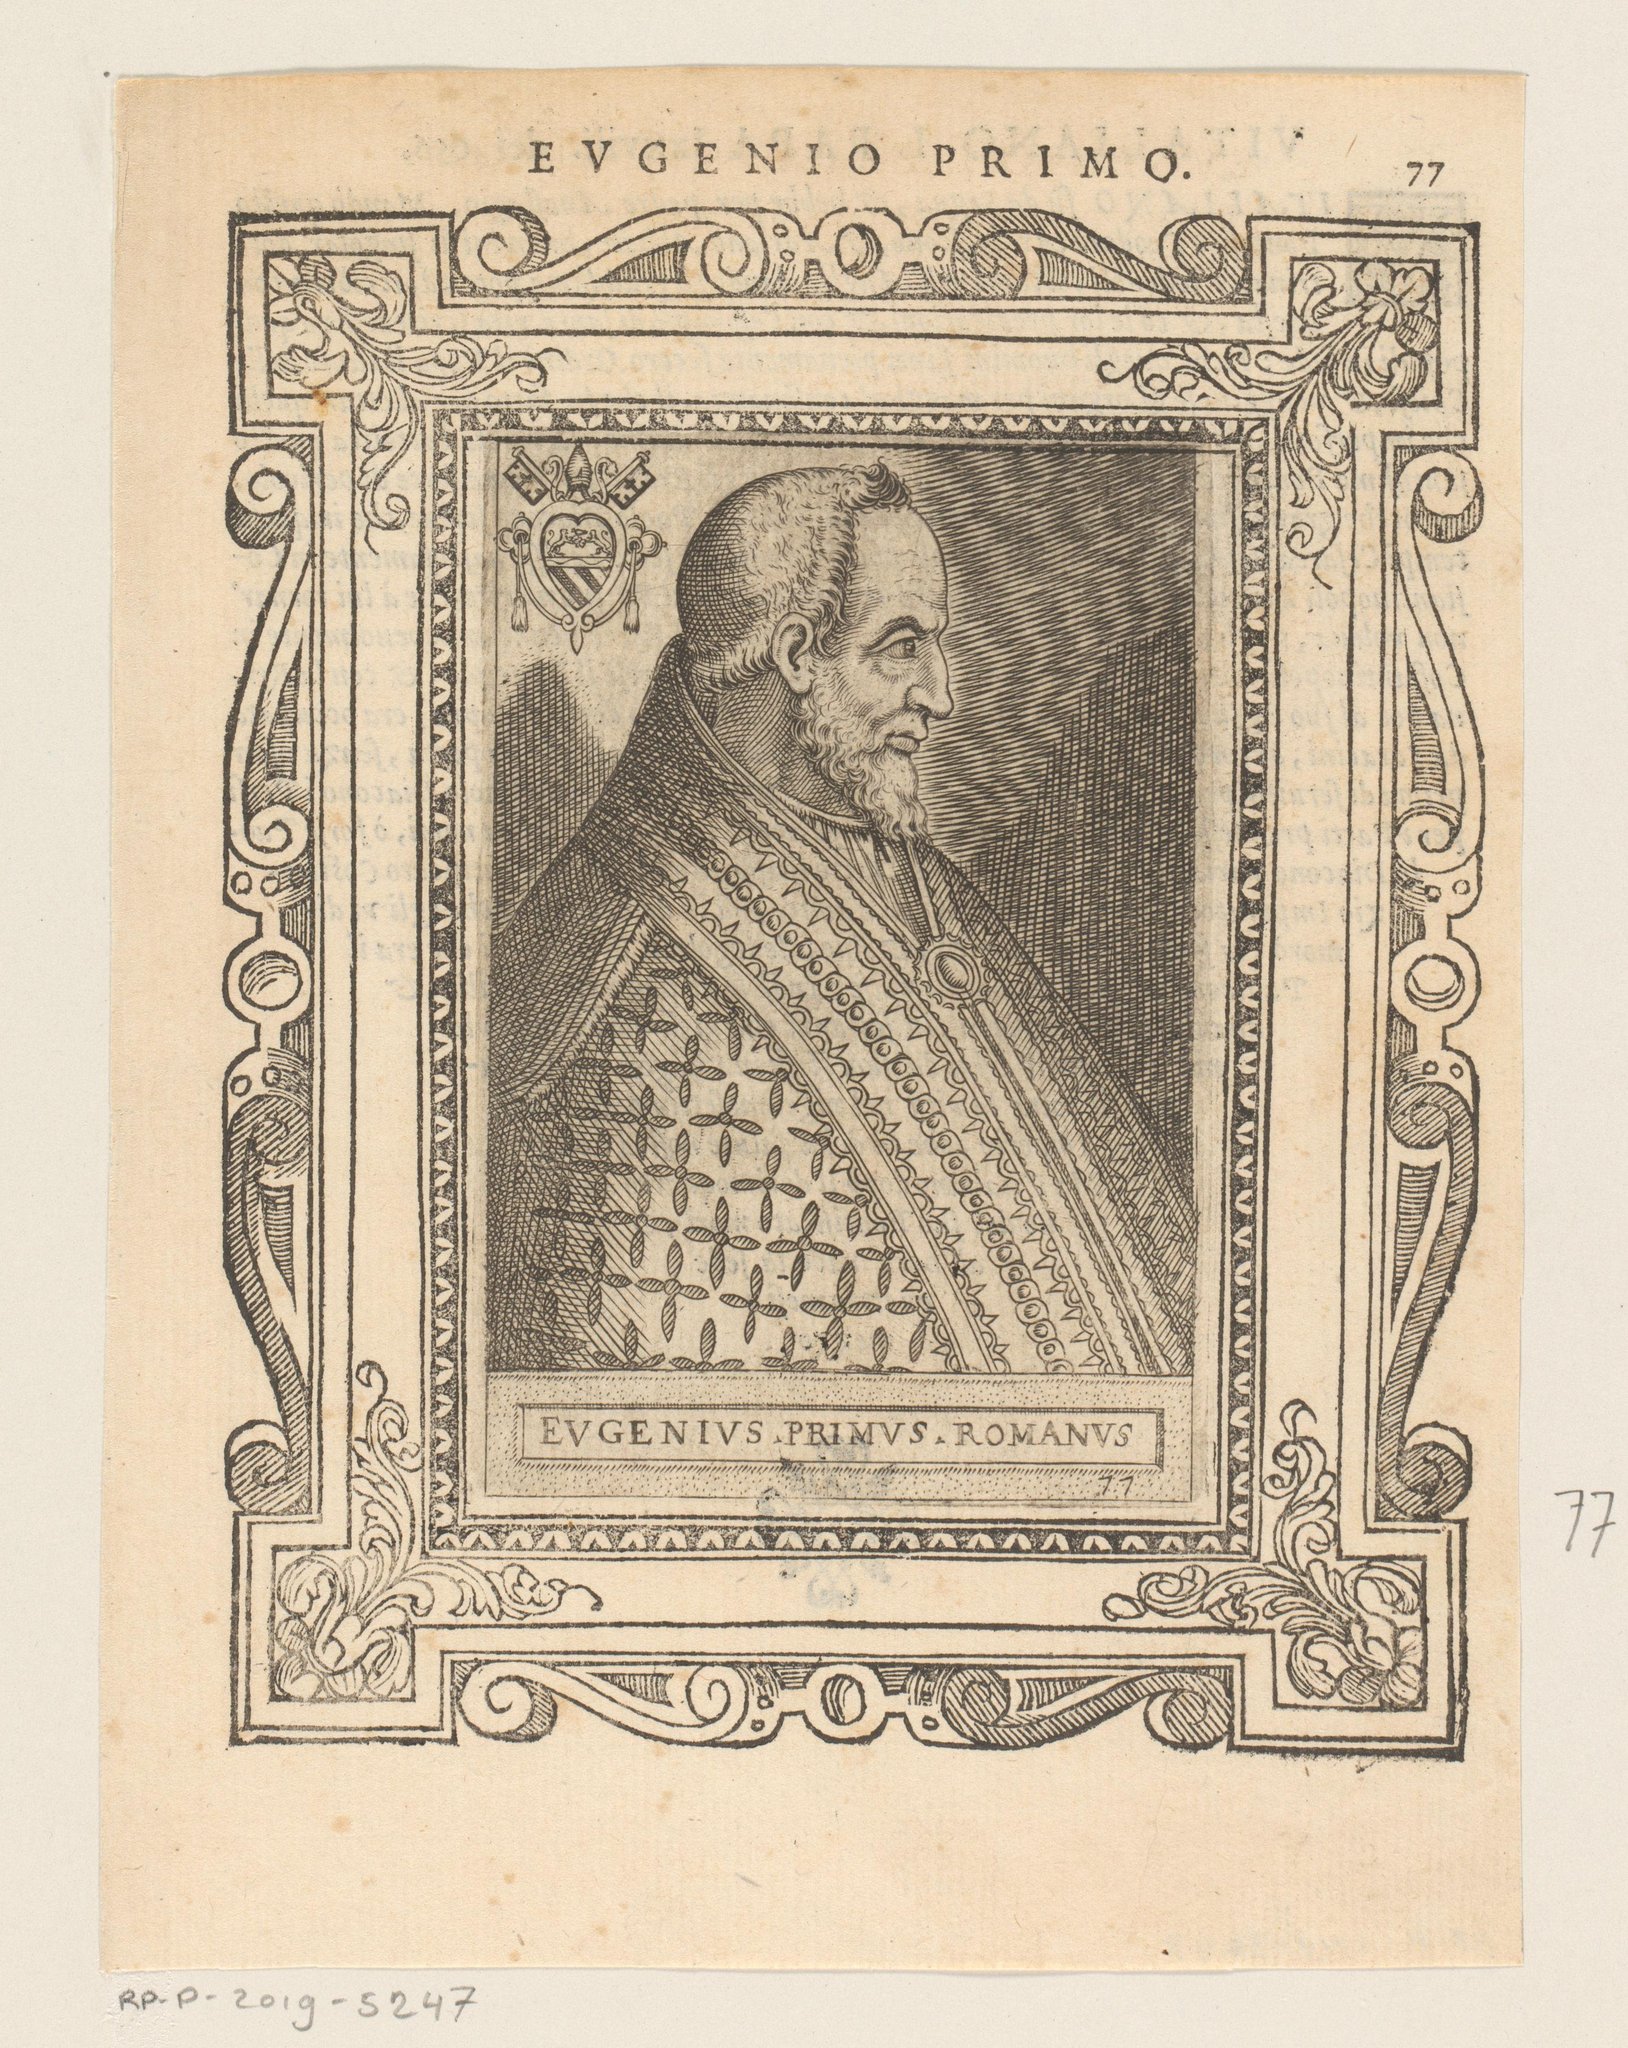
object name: print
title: Portret van paus Eugenius I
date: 1587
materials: paper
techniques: engraving, letterpress printing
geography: rome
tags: rome, historical persons, pope, armorial bearing, heraldry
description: Prent uit: Ciccarelli, Antonio. Le vite de Pontefici di Antonio Ciccarelli (...). Rome: Domenico Basa, 1587. Prent voor het eerst verschenen in: Cavalieri, Giovanni Battista de'. Pontificum romanorum effigies (...). Rome: Domenico Basa en Francesco Zanetti, 1580. Prent ook gebruikt in latere publicaties.